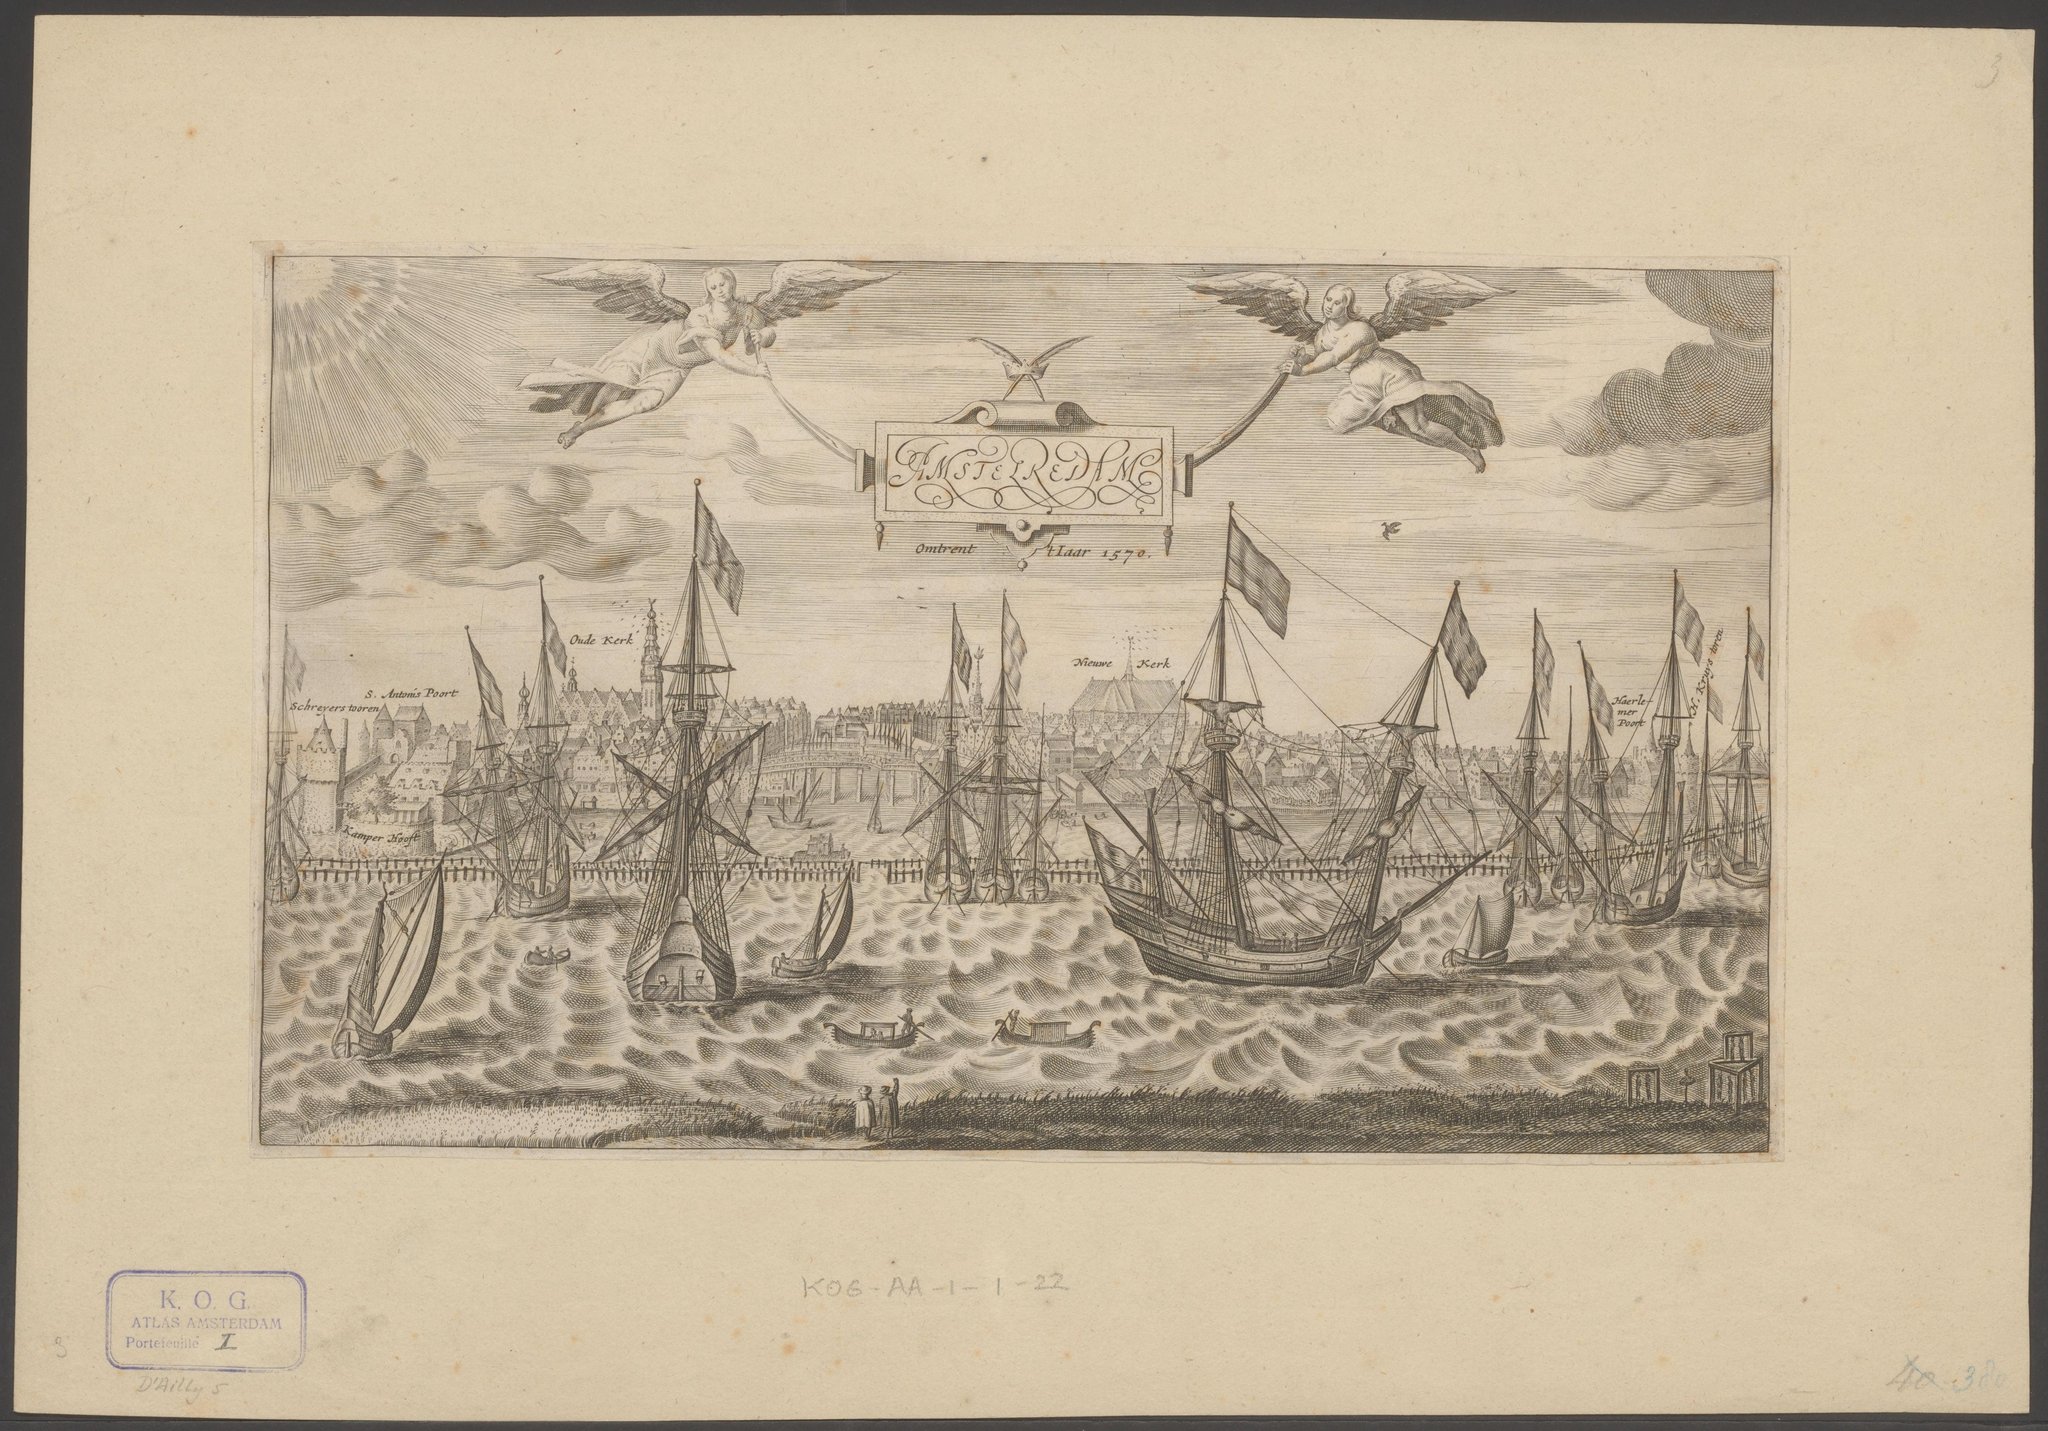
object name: print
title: Amstelredam Omtrent 't Iaar 1570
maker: Anonymous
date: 1600-1699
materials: paper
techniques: engraving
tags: city-view in general; 'veduta', river, ships (in general) - cc - more than one ship, amsterdam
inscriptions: collector's mark: ‘1’ Lugt 1641b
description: Onderwerpsrubriek binnen de Atlas Amsterdam: Gezichten van den geheelen IJkant der Stad.